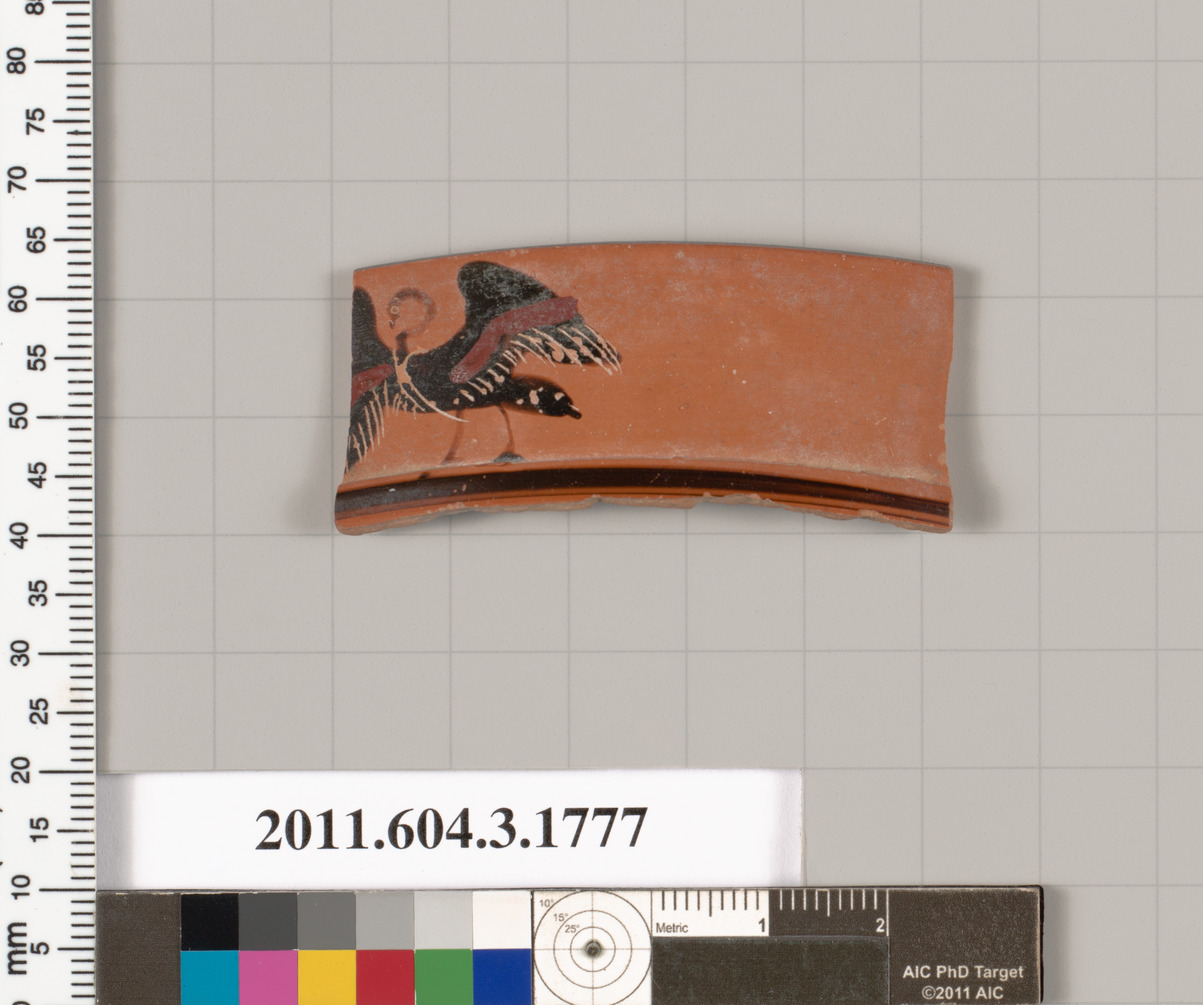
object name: kylix fragment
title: Terracotta rim fragment of a kylix: Lip cup (drinking cup)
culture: greek, attic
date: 560-550 BCE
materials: terracotta